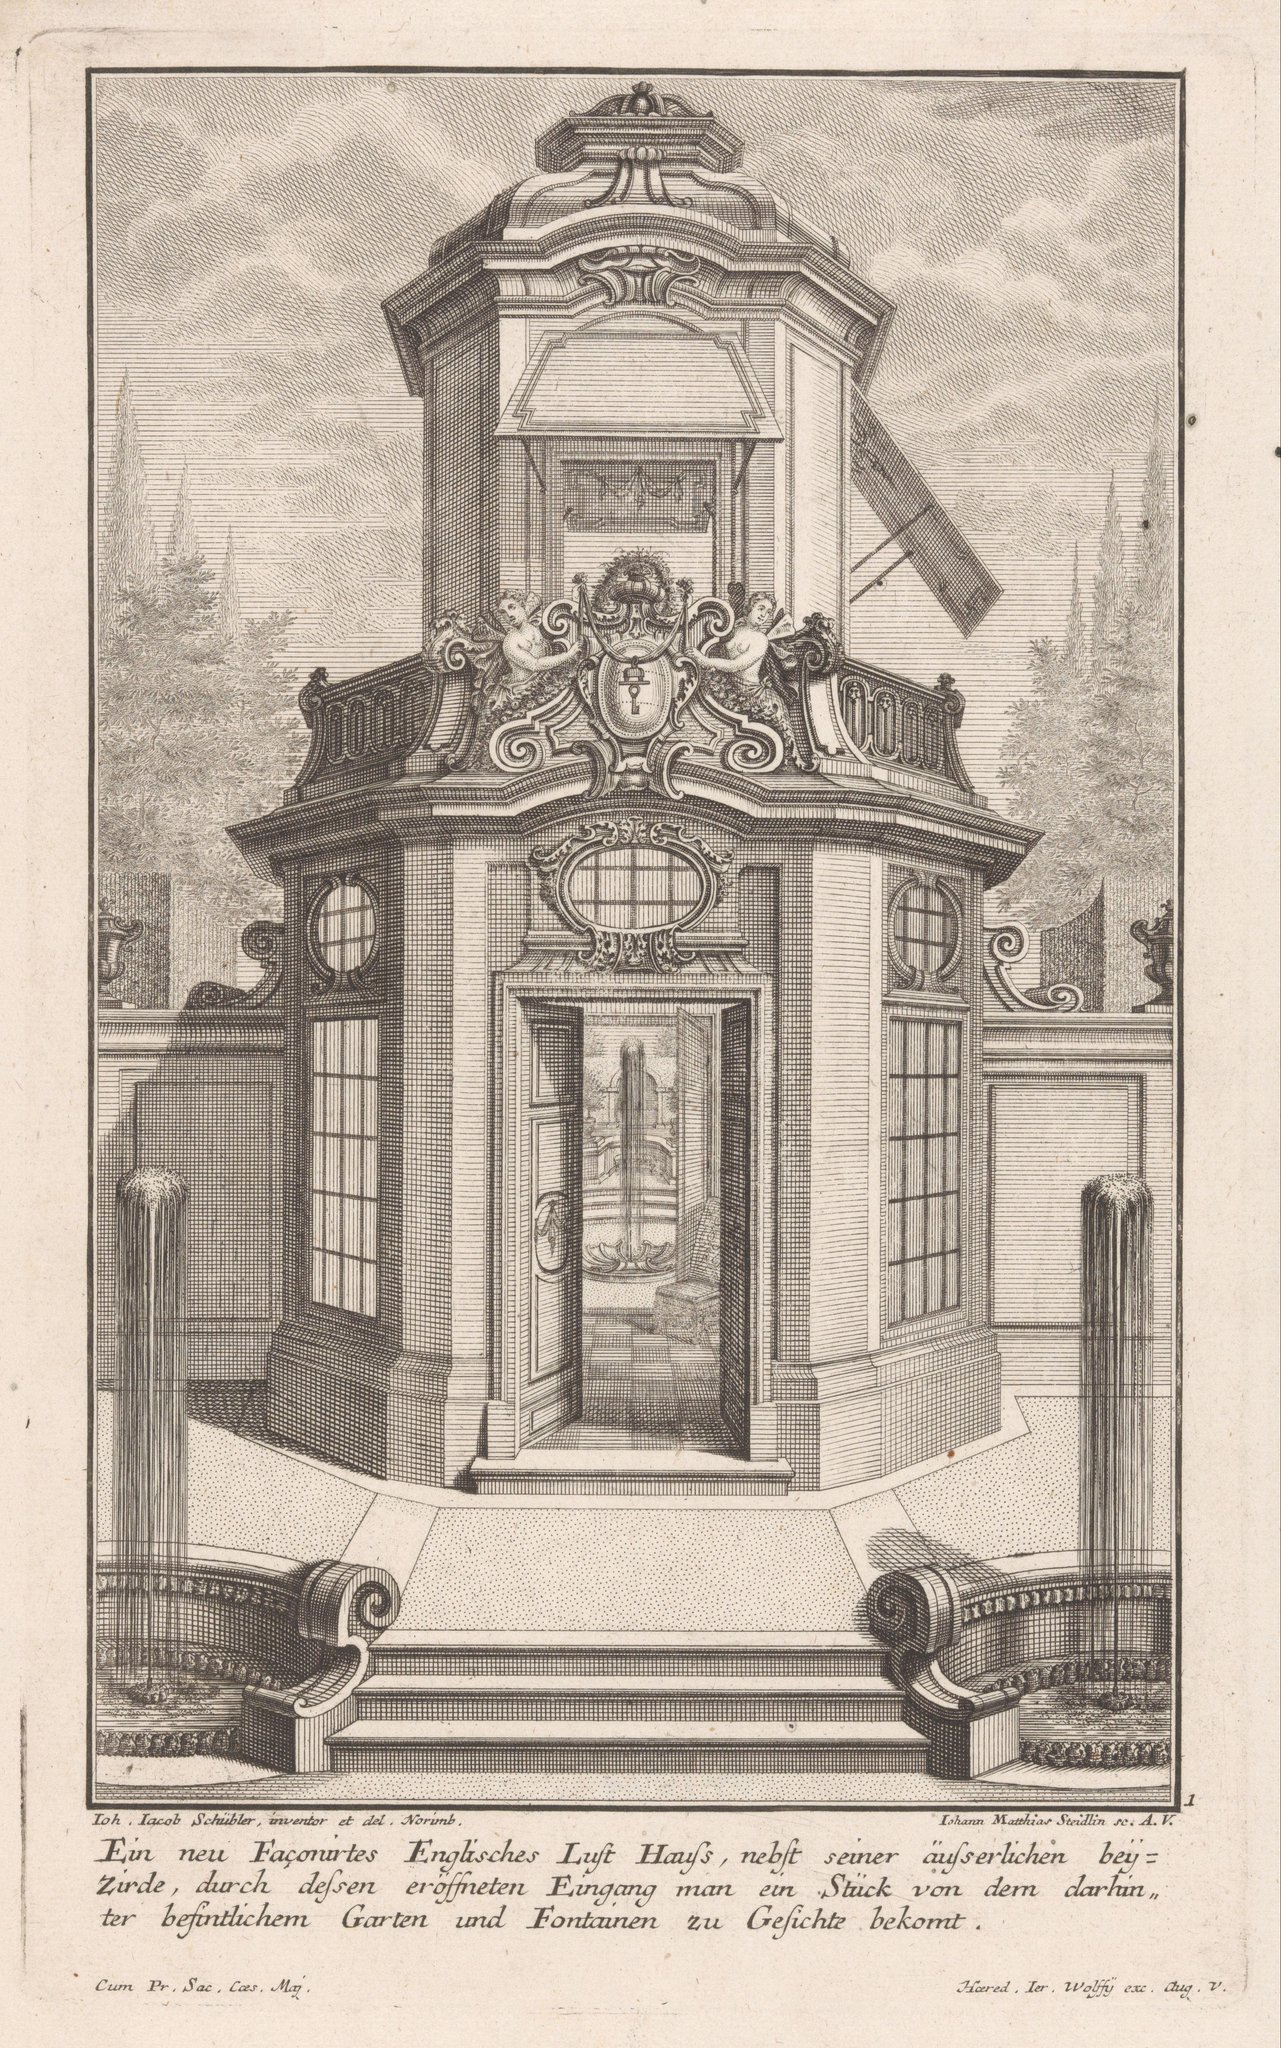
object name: print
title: Johann Jacob Schüblers Siebende Ausgabe seines vorhabenden Wercks, Worinnen vorgestellet werden Neu-inventierte Sommer-Häuser, Garten-Cabinetten (...)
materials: paper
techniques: engraving, etching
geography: nuremberg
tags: garden fountain, summer-house, arbour, garden-house (dutch: 'theekoepel'), cupids: 'amores', 'amoretti', 'putti'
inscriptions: collector's mark: Lugt 2228, collector's mark: Lugt 2760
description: Een geornamenteerd tuinhuis met putti en wapenschild. De deur van het tuinhuis is geopend en biedt een doorkijk naar een tuin met fontein in de achtergrond. Op de voorgrond twee fonteinen. In de ondermarge een drieregelige Duitse tekst.